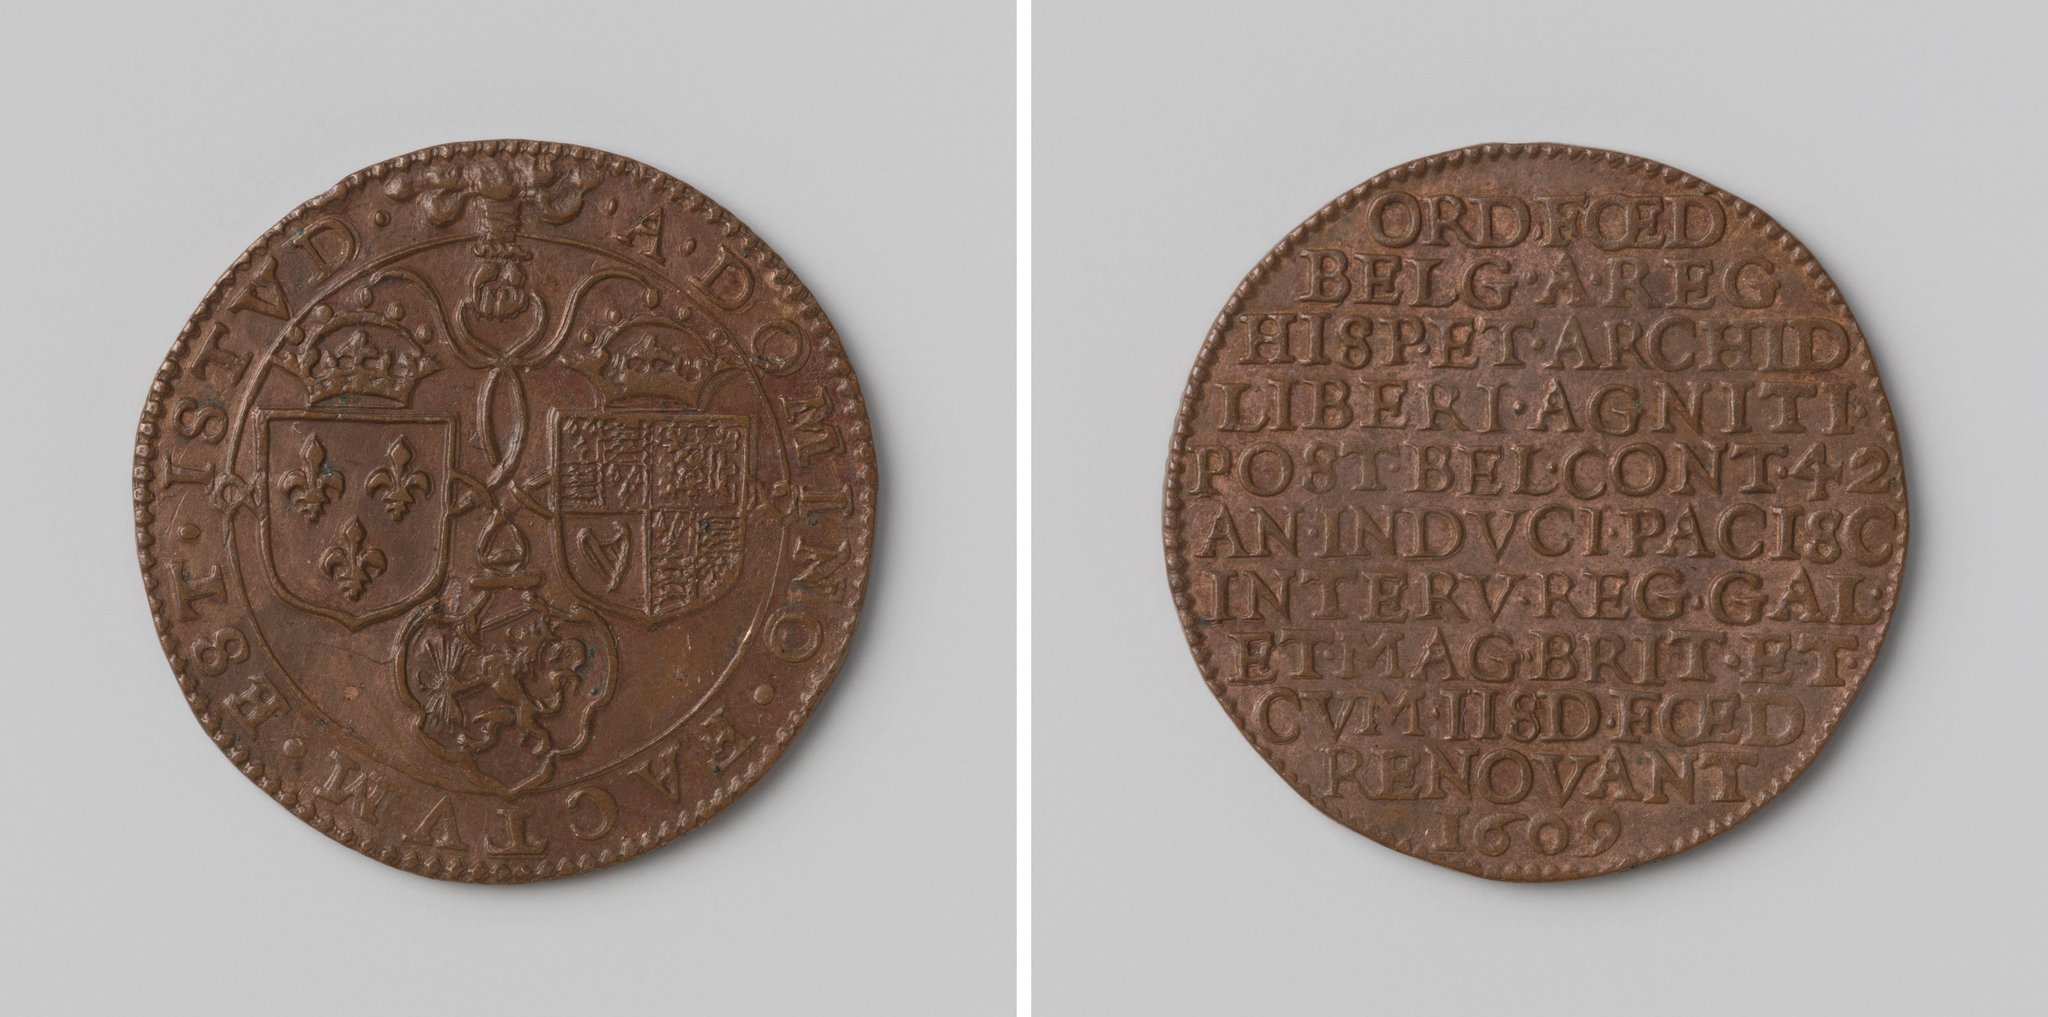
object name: jeton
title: Sluiting van het Twaalfjarig Bestand tussen de Republiek en Spanje, en hernieuwing van het drievoudige verbond tussen Engeland, Frankrijk en de Republiek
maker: Anonymous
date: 1609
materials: copper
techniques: striking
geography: netherlands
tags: netherlands, france, england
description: Koperen penning. Voorzijde: hand uit wolken houdt lint vast, waaraan een ongekroond en twee gekroonde wapenschilden hangen binnen omschrift. Keerzijde: opschrift.